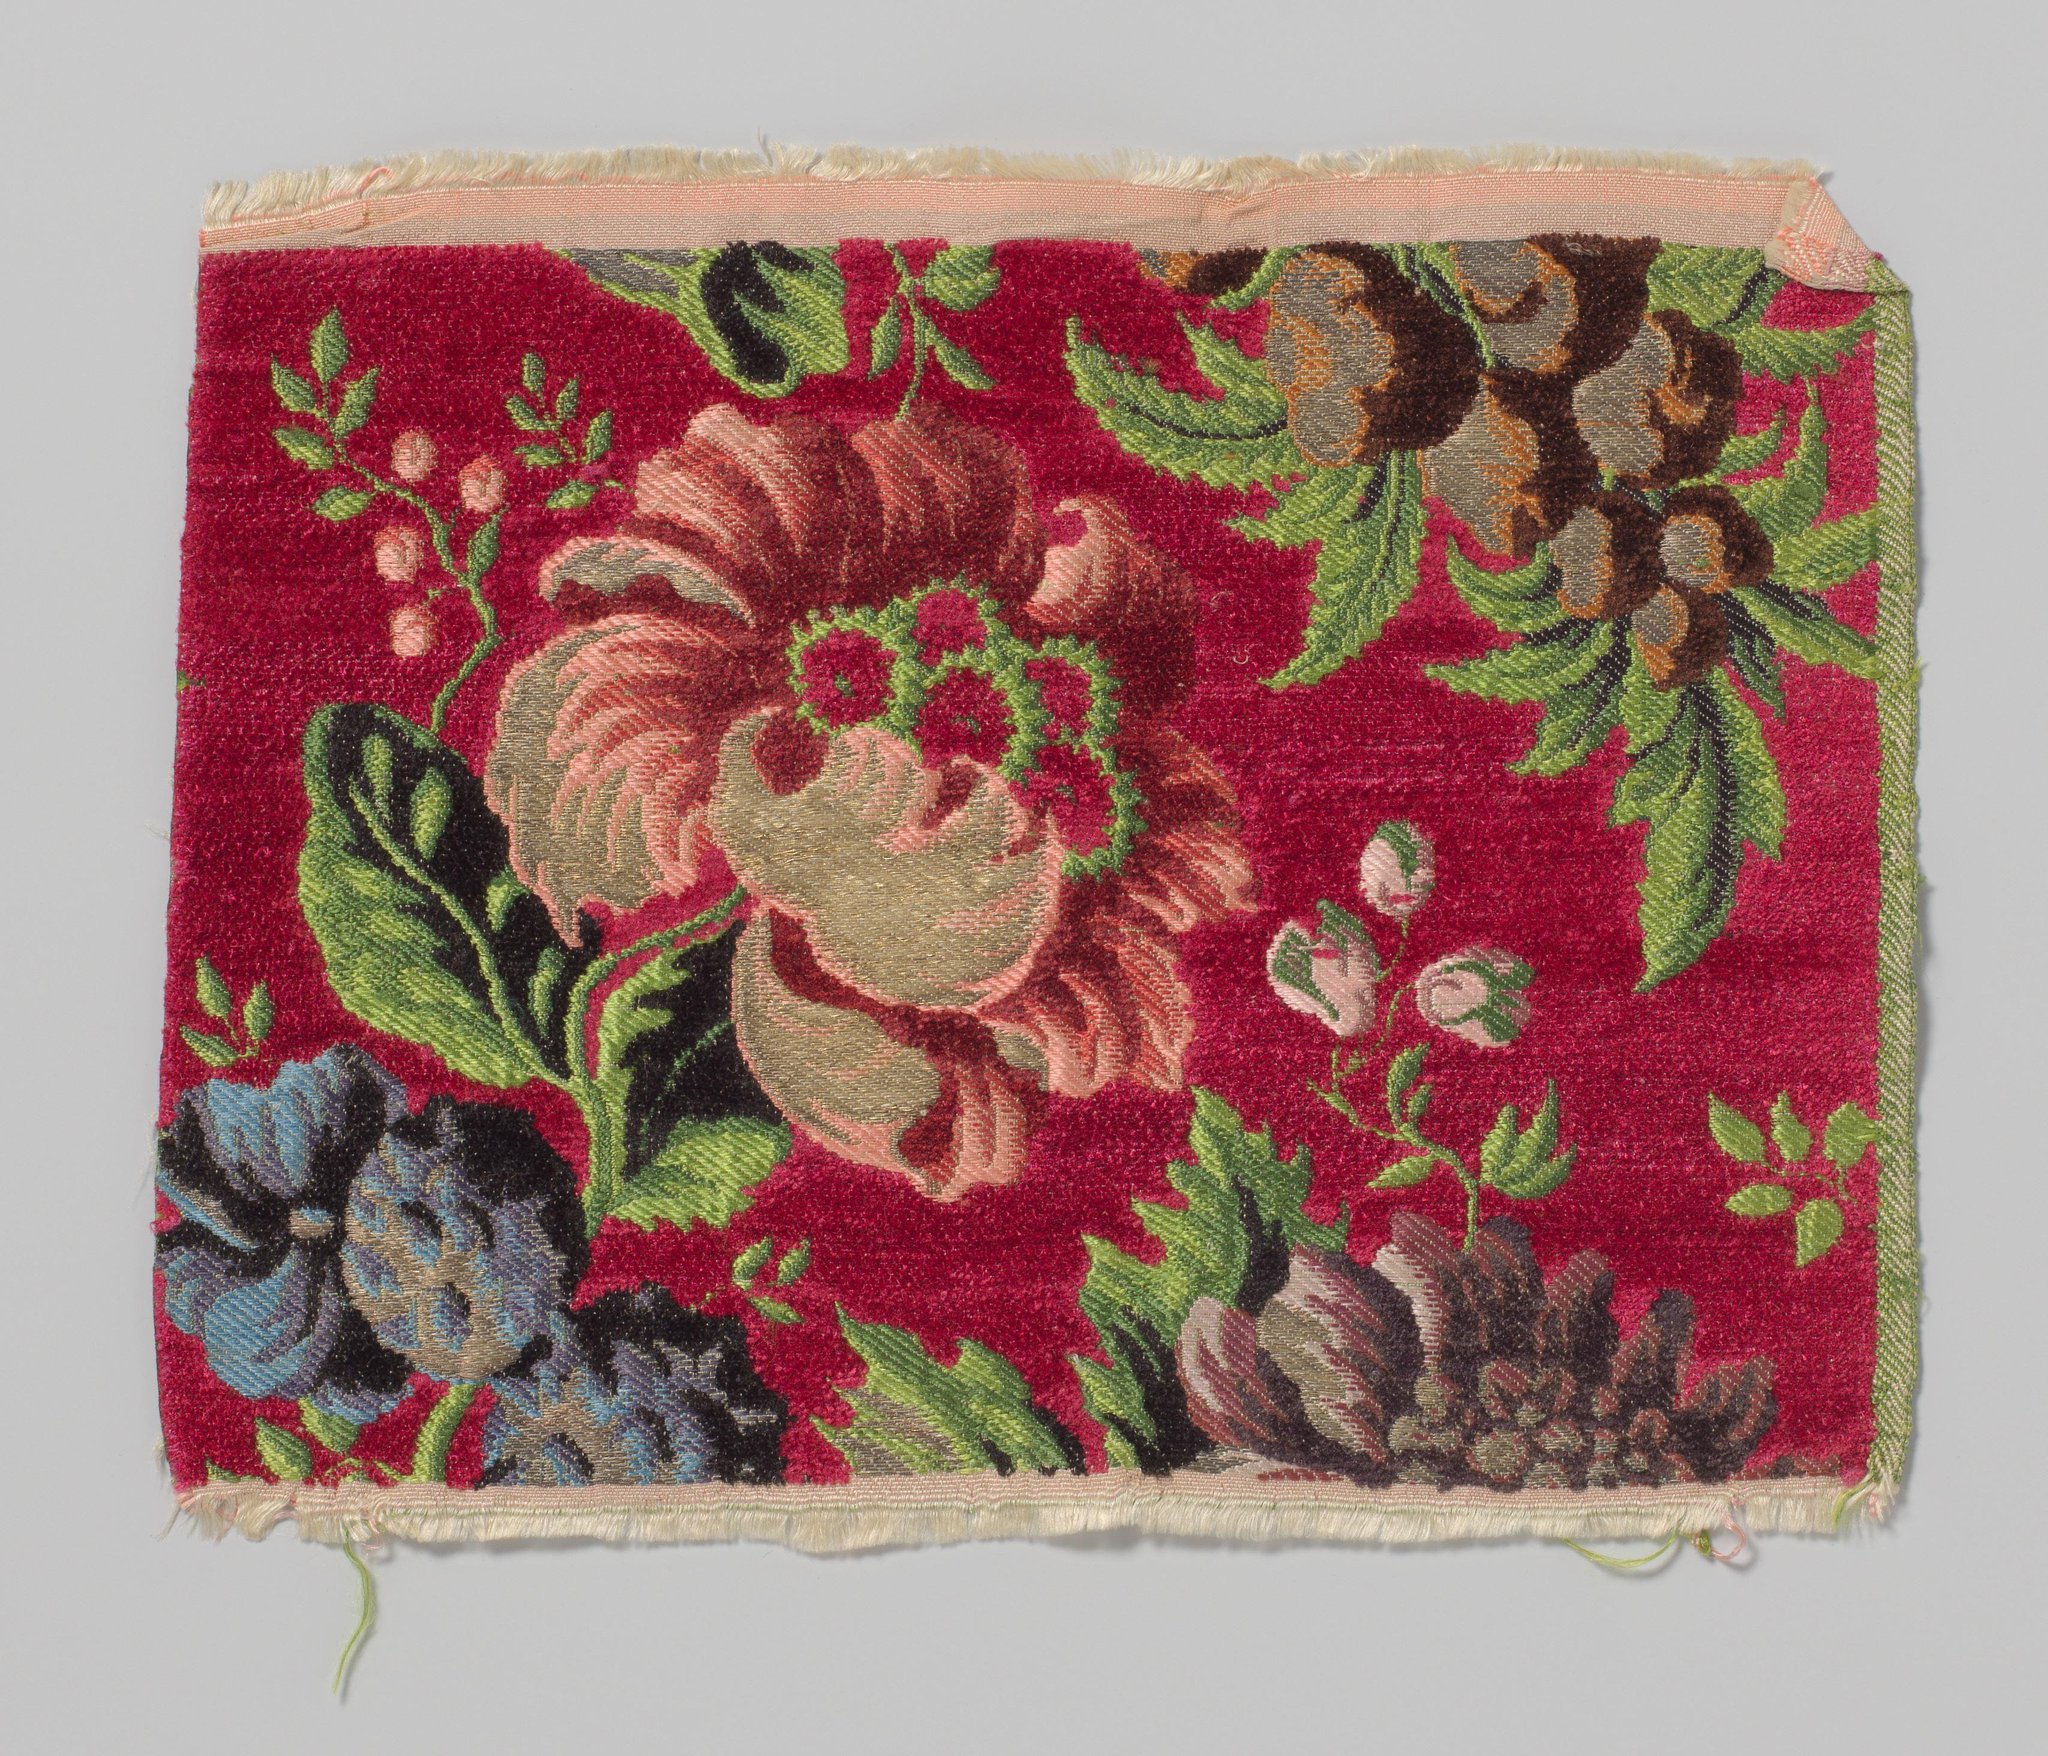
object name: fragment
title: Fragment zijdeweefsel met cérise fond van chenille, waarop een klaproos in metaaldraad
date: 1735-1740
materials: gold thread, silk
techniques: brocade, weave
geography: france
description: Fragment zijdeweefsel met een onvolledig, asymmetrisch patroon: een felgroen slingerende bladtak, iets schuin rechts gericht, draagt een grote klaproos in gouddraad en lichtroze, gerand in zalmroze, met donkerrode chenille schaduwen en een hart van vijf cérise chenille bloemen met groene randen. Linksonder, half afgesneden, een purpere bloem met gouddraad en donkerpaarse chenille schaduwen. Rechtsboven een hangende bladtak met een tros vruchten in gouddraad, oranje zijde en donkerbruine chenille.